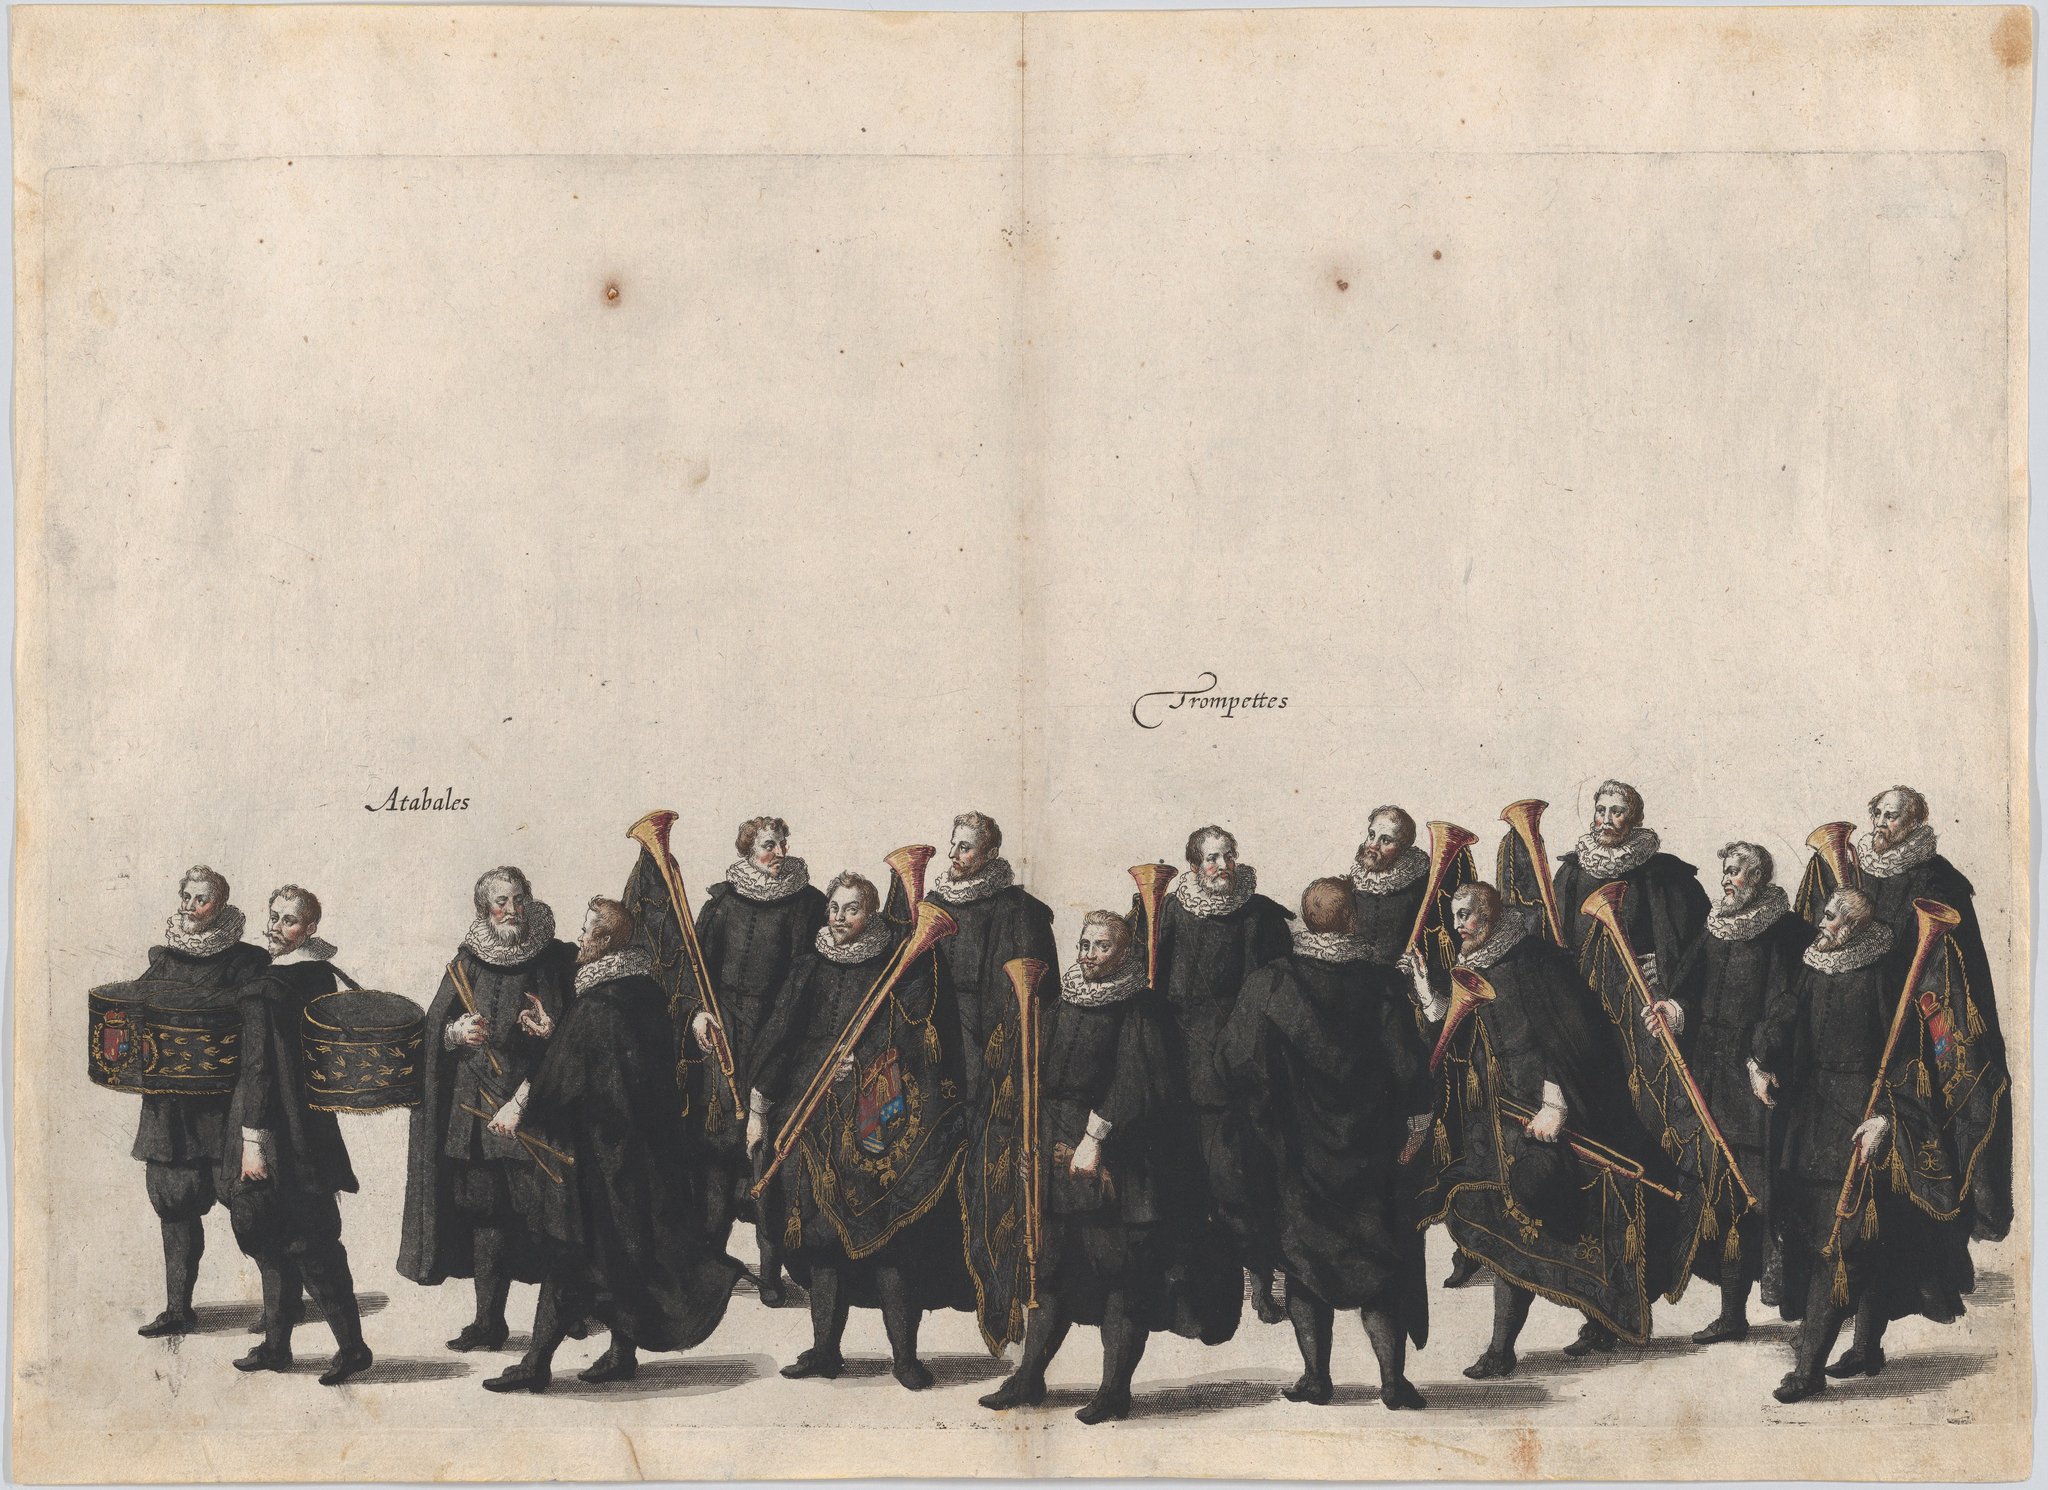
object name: print, fete, ornament architecture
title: Plate 28: Drummers and trumpet players marching in the funeral procession of Archduke Albert of Austria; from 'Pompa Funebris ... Alberti Pii'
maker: cornelis galle (i)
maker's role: artist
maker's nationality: netherlandish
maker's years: 1576-1650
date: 1623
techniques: etching, hand coloring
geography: brussels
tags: men,drums,trumpets,musicians